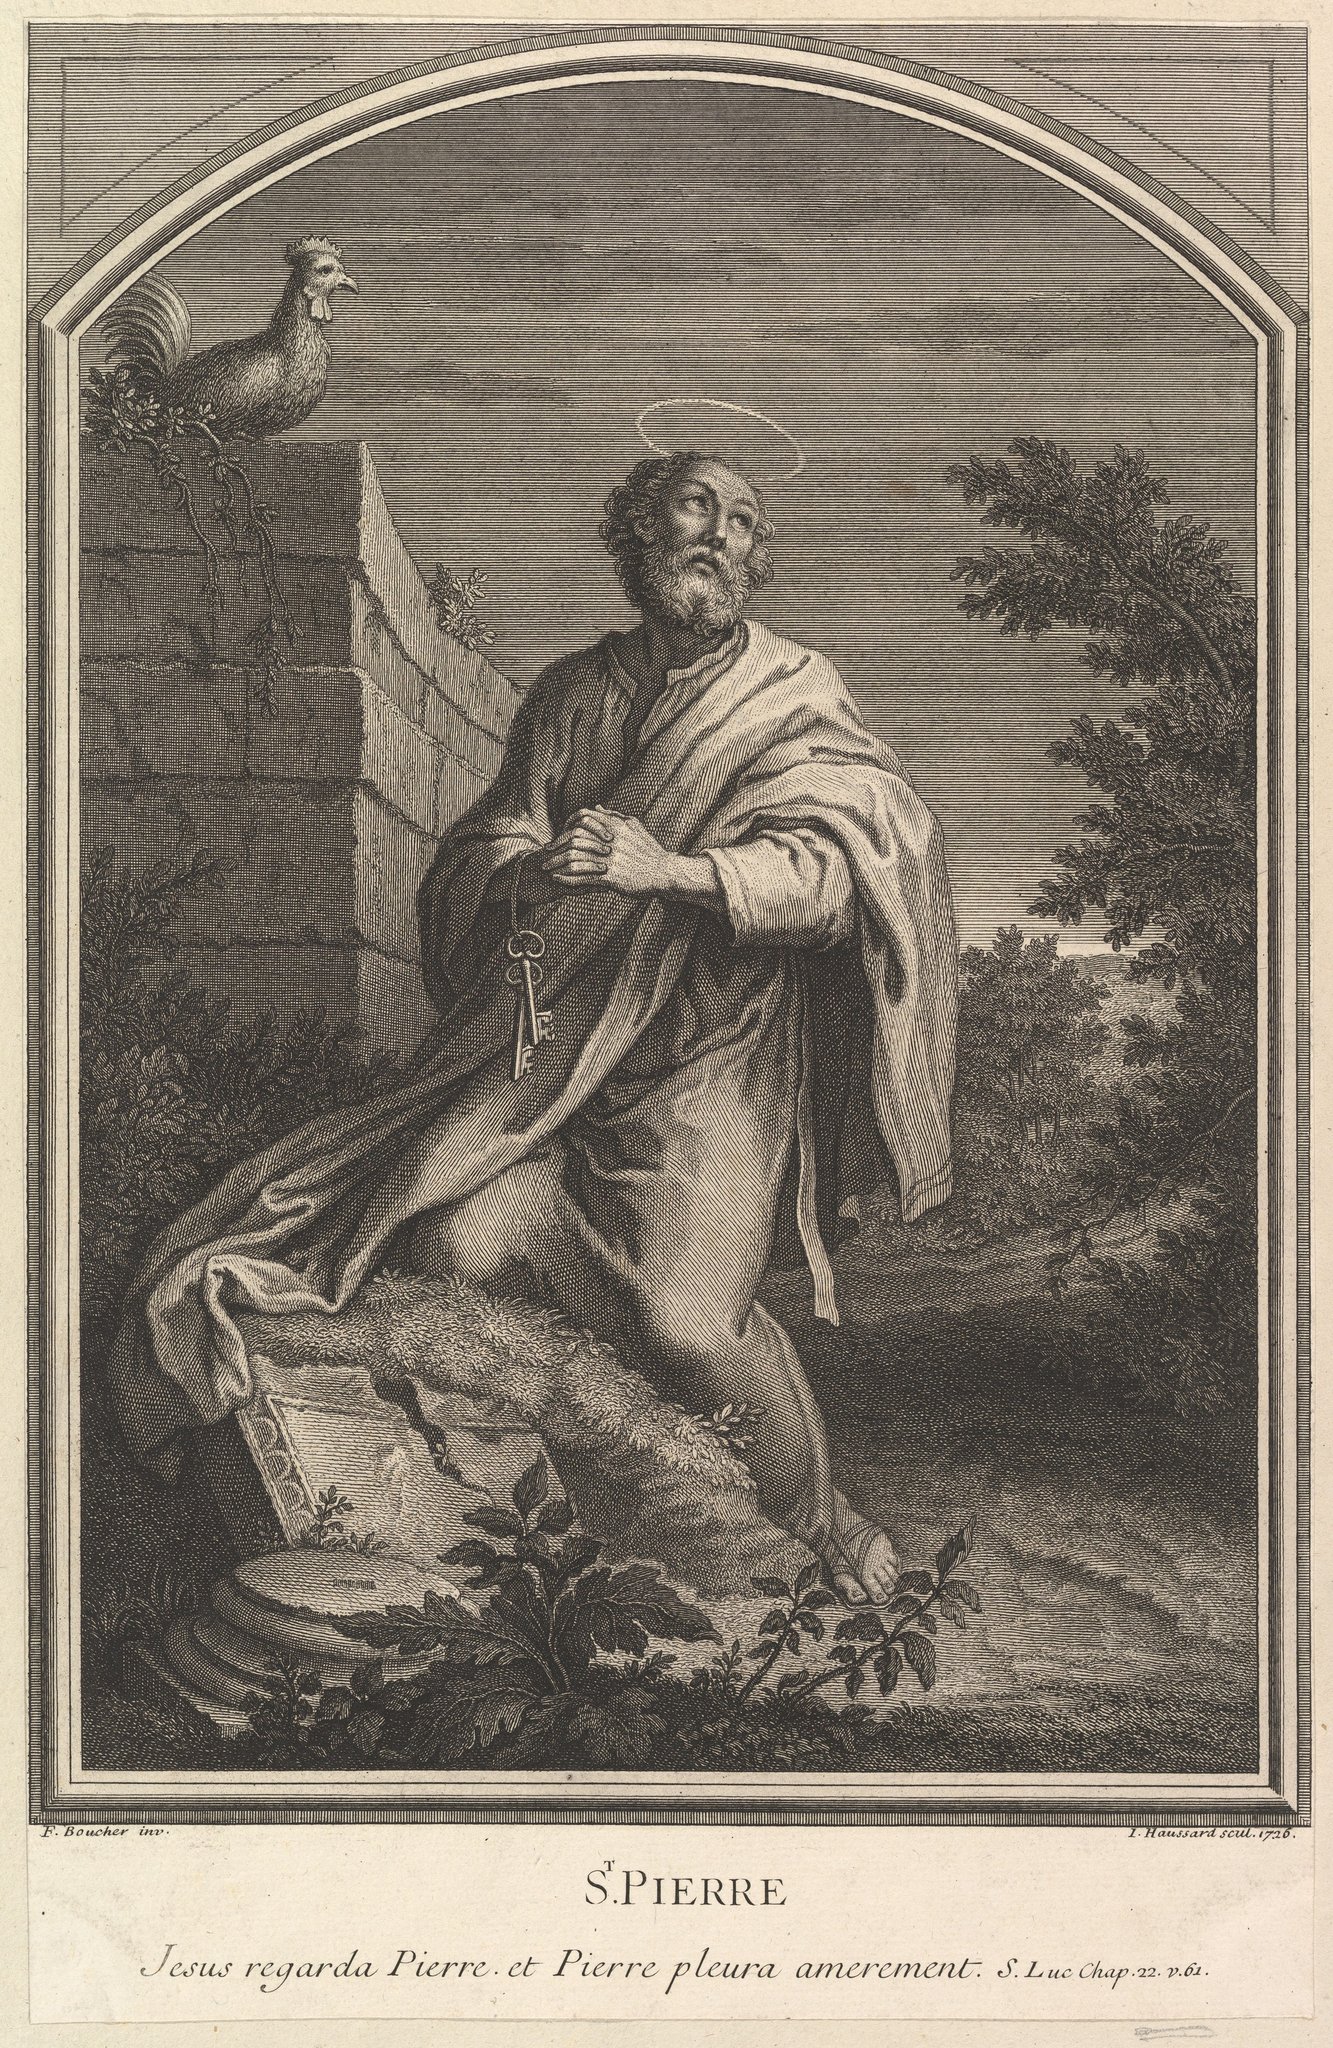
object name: print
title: Saint Pierre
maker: jean-baptiste haussard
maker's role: artist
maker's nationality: french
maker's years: 1679-1749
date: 1726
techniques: engraving, etching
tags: saints